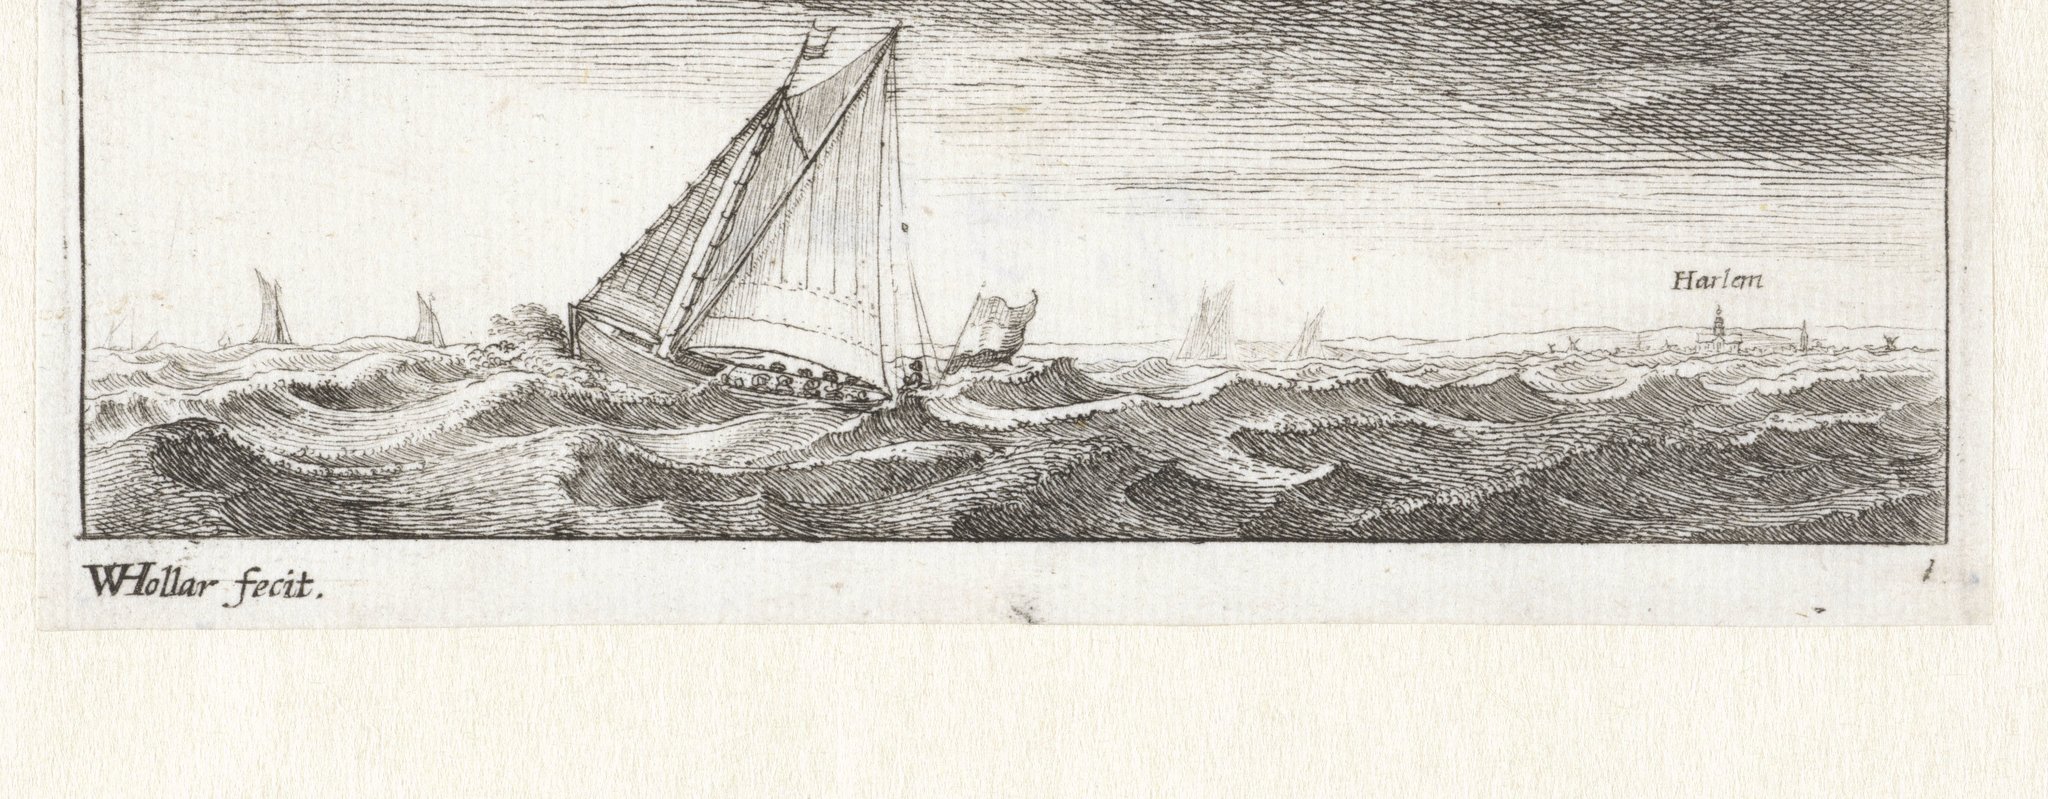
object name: print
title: Kleine zeegezichten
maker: wenceslaus hollar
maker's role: draughtsman, print maker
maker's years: 1607-1677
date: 1627-1636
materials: paper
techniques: etching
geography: germany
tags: sailing-ship, sailing-boat, landscapes with waters, waterscapes, seascapes (in the temperate zone)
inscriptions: collector's mark: Lugt 2228